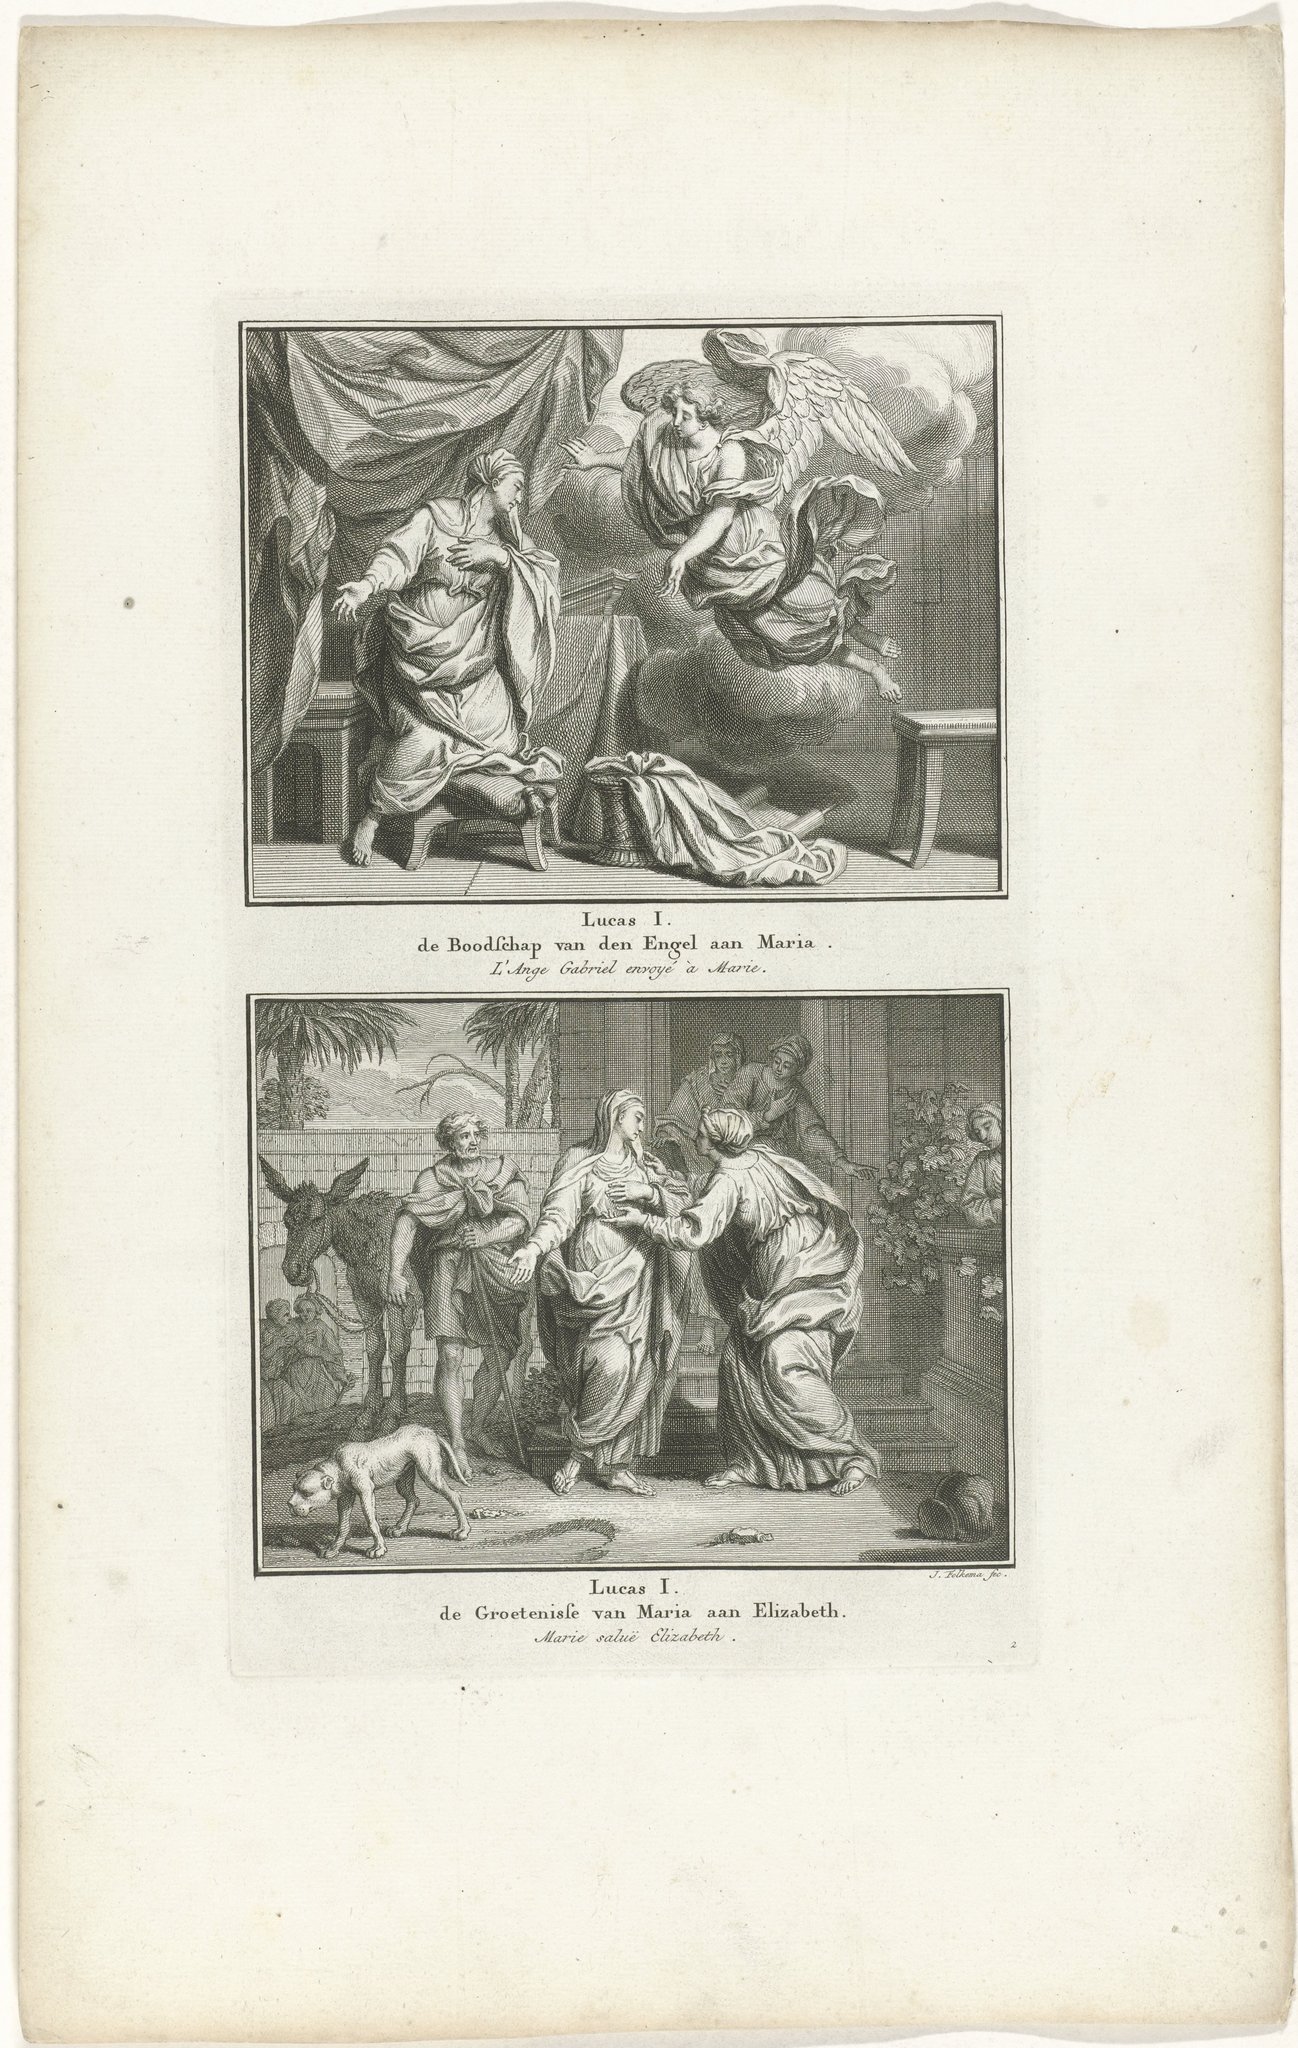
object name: book illustration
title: Annunciatie en Visitatie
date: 1791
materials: paper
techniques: etching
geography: amsterdam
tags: mary and elisabeth shaking hands, the annunciation: mary, usually reading, is visited by the angel (sometimes a woman overhears the conversation)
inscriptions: collector's mark: Lugt 2233, collector's mark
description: Illustratie uit: Hamelsveld, Ysbrand van. De gewigtigste geschiedenissen des Bybels, afgebeeld in twee honderd twee en vijftig printverbeeldingen (...) met eene zaaklijke uitbreiding opgehelderd. Amsterdam / Dordrecht: Jan de Groot / Abraham en Pieter Blussé.